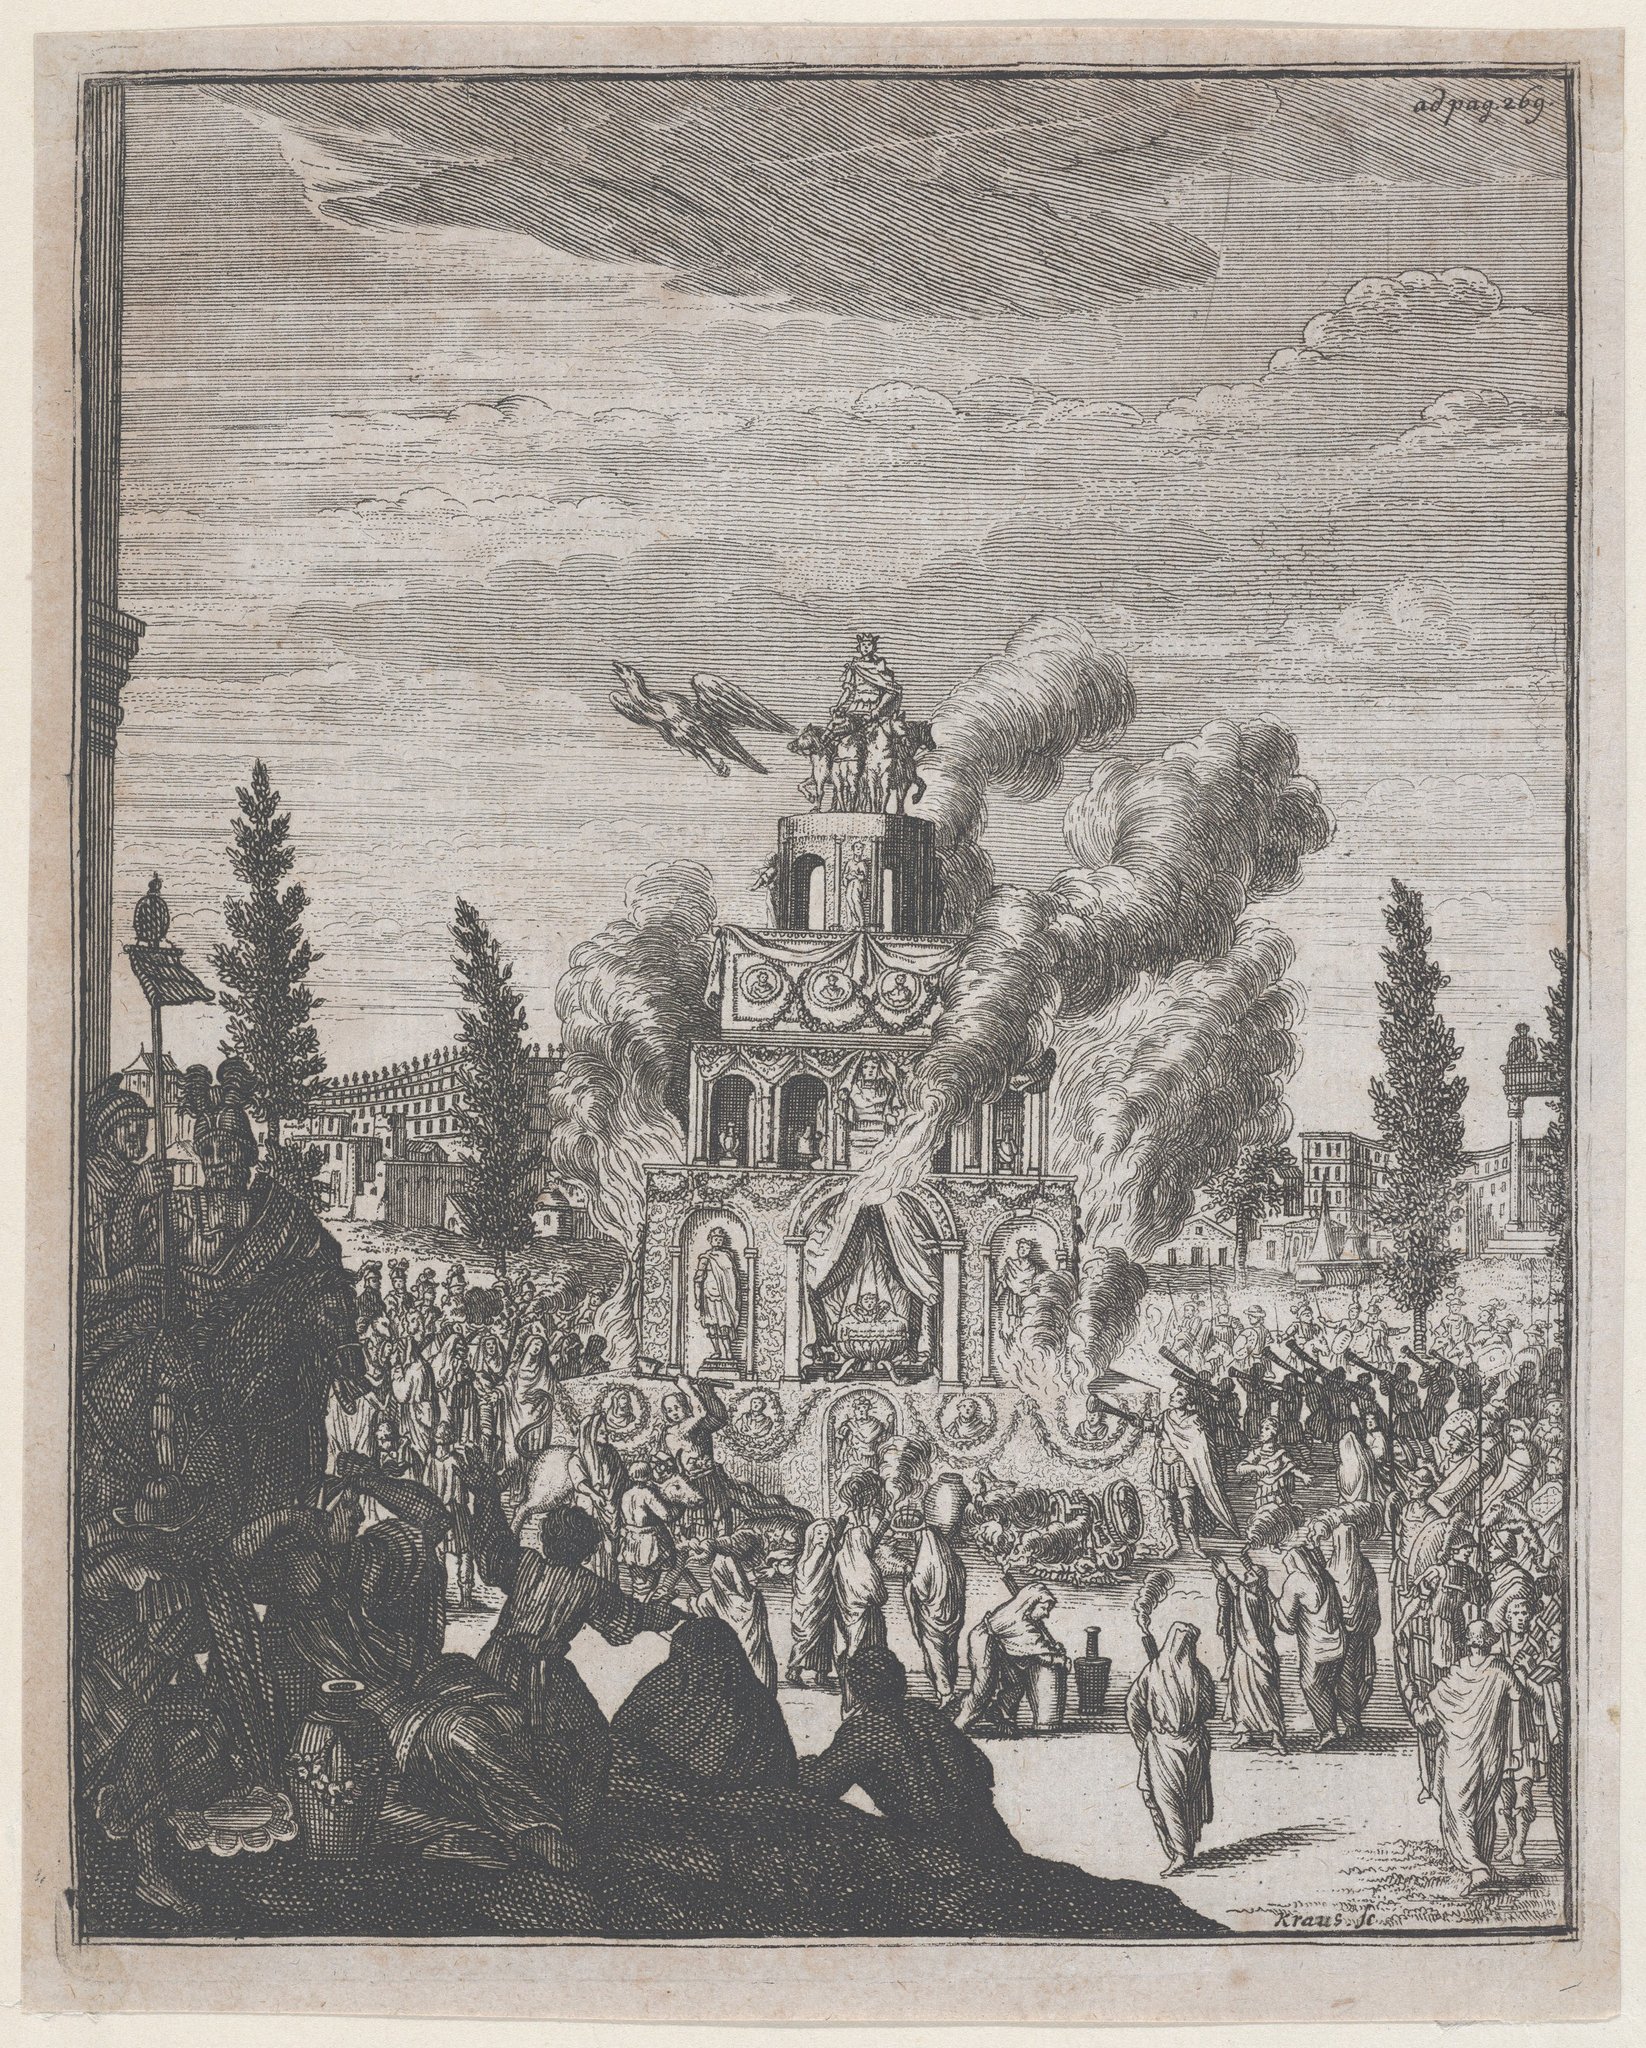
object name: print, fete, ornament architecture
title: A Celebration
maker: johann ulrich kraus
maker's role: artist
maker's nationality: german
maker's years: 1655-1719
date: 1675-1719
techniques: etching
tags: birds,buildings,men,women,crowd